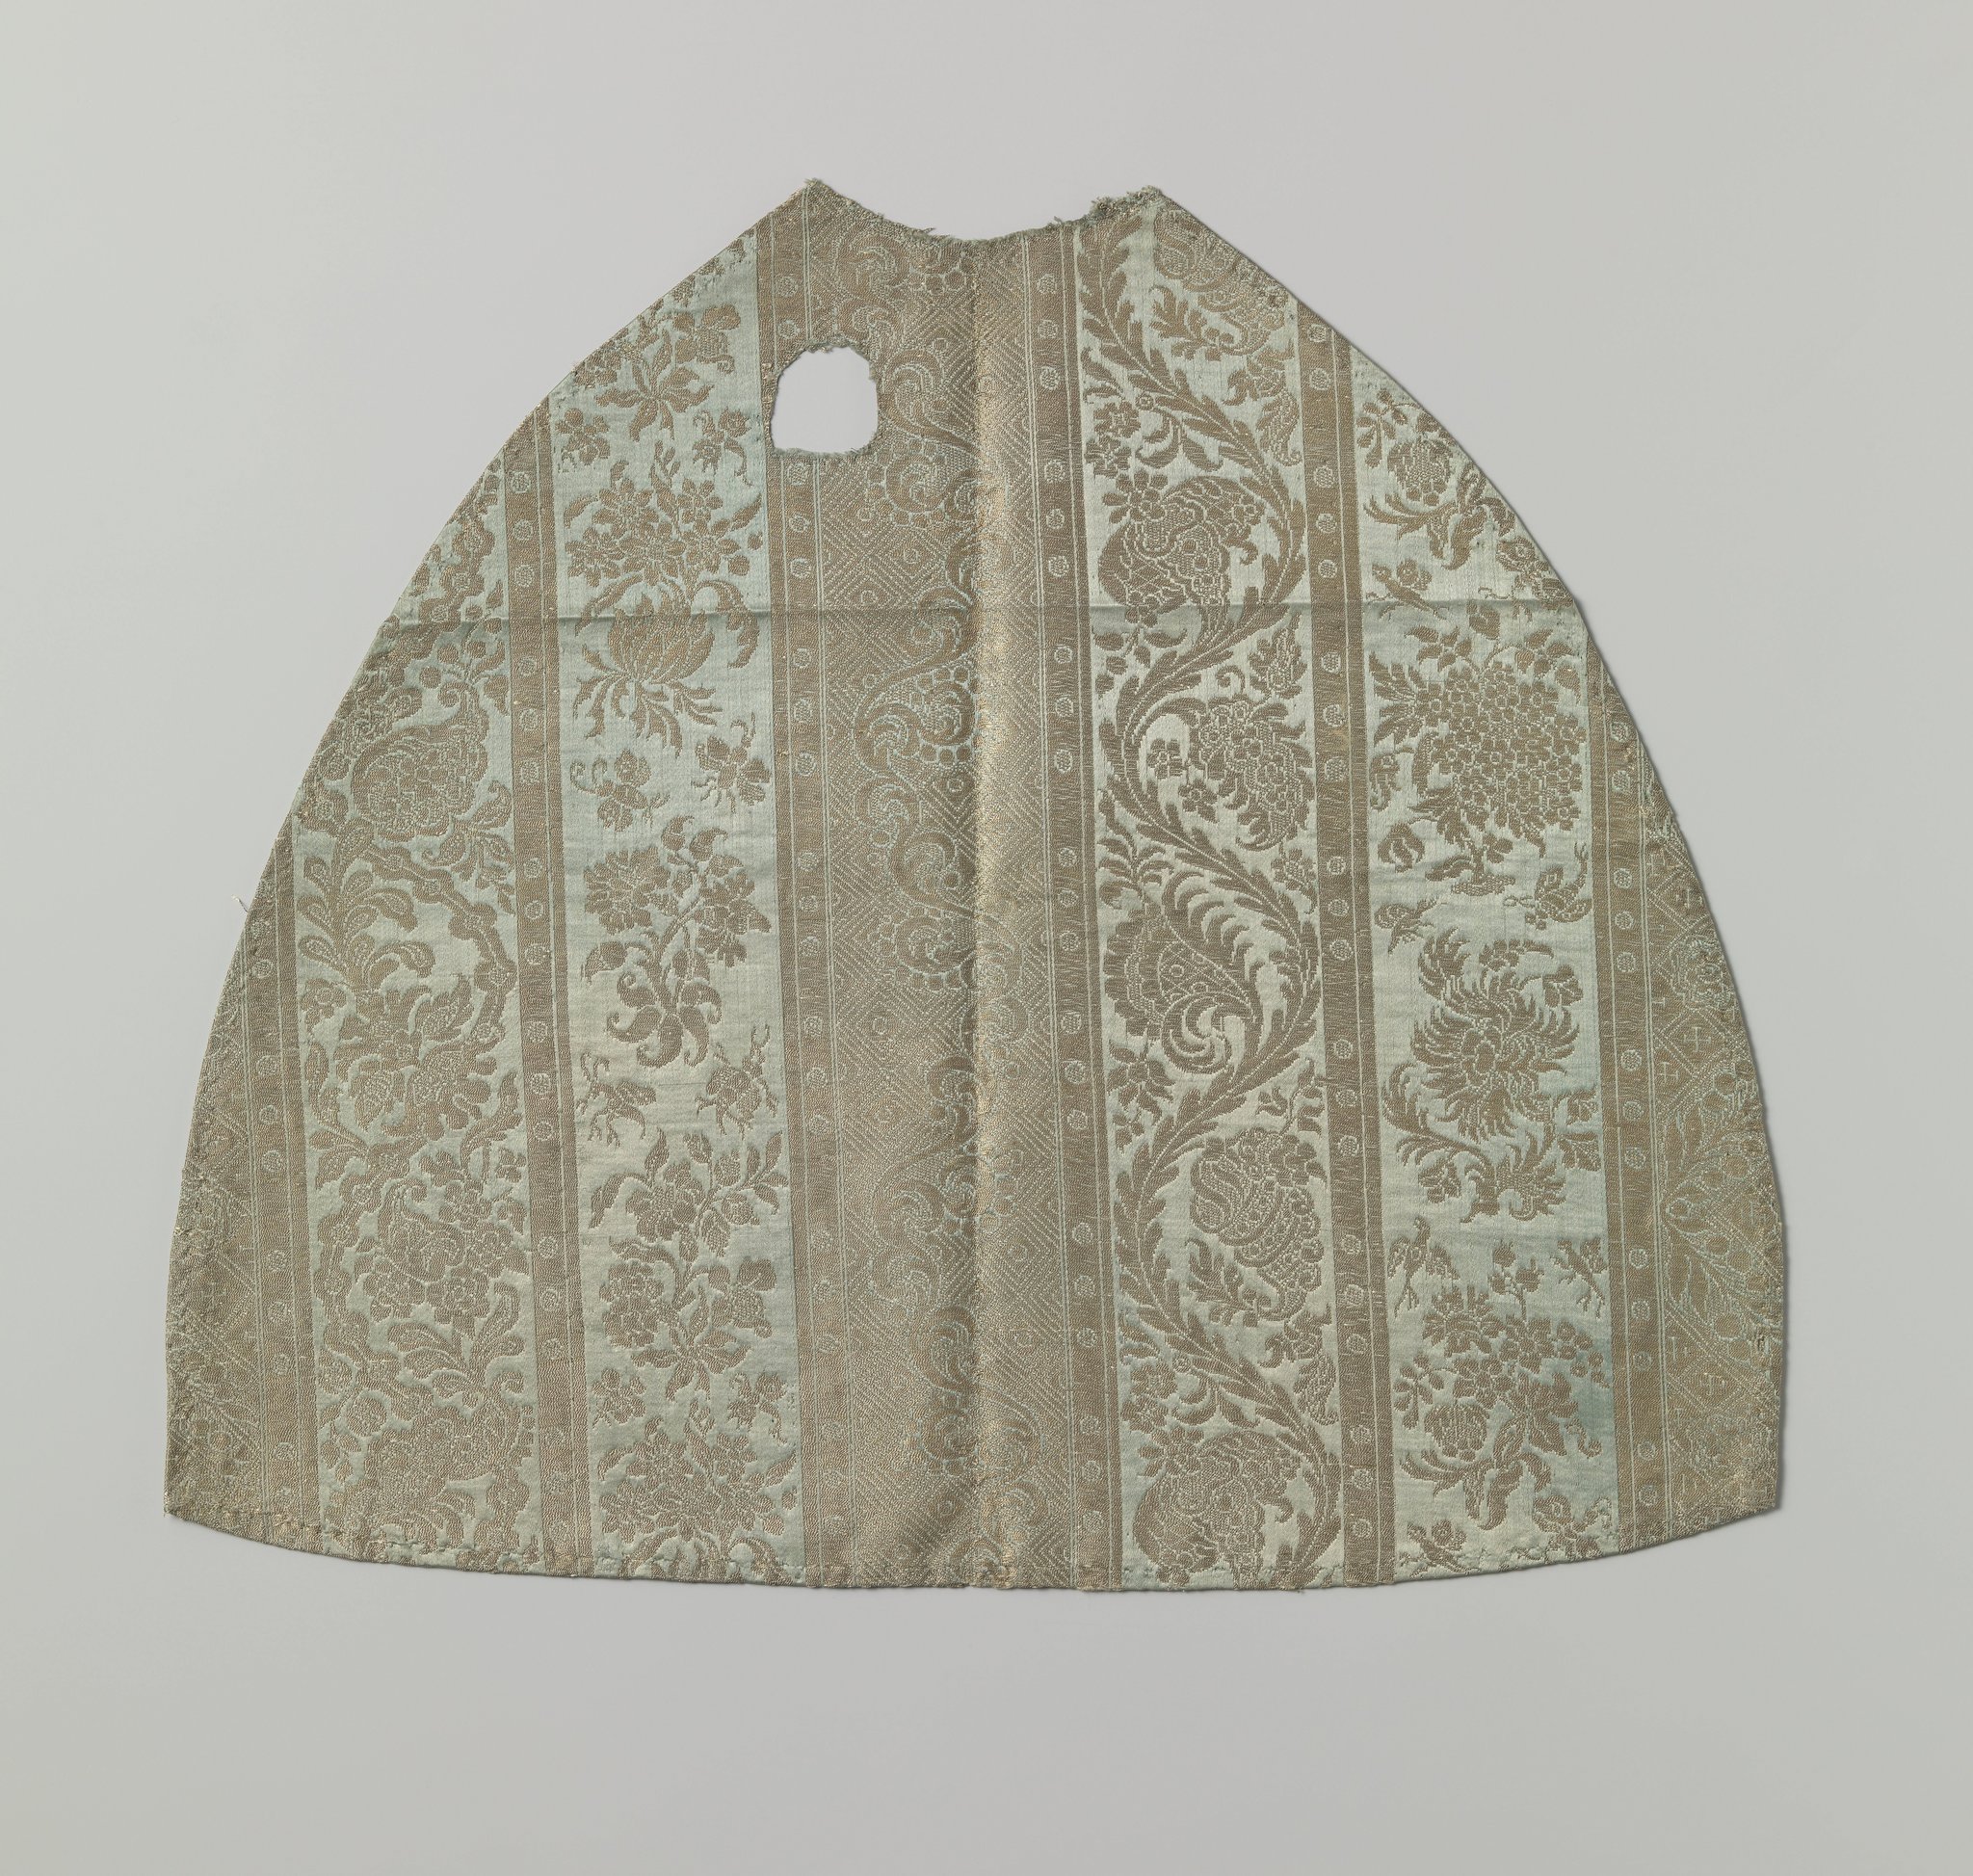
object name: satijnbrokaat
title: Fragment van een zijden satijnbrokaat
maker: Anonymous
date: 1750-1800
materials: gold thread, silk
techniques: launching, liseré, satin binding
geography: france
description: Fragment van een zijdeweefsel in onregelmatige vorm met een ronde uitsnijding; wellicht ooit gebruikt voor kind Jezussculptuur. Het patroon is van goud op blauwe zijde (groen verschoten) en heeft een patroon van afwisselend een baan waarbinnen geometrische vormen, een baan waarbinnen bloemboeketten en een baan waarbinnen bloemslingers.